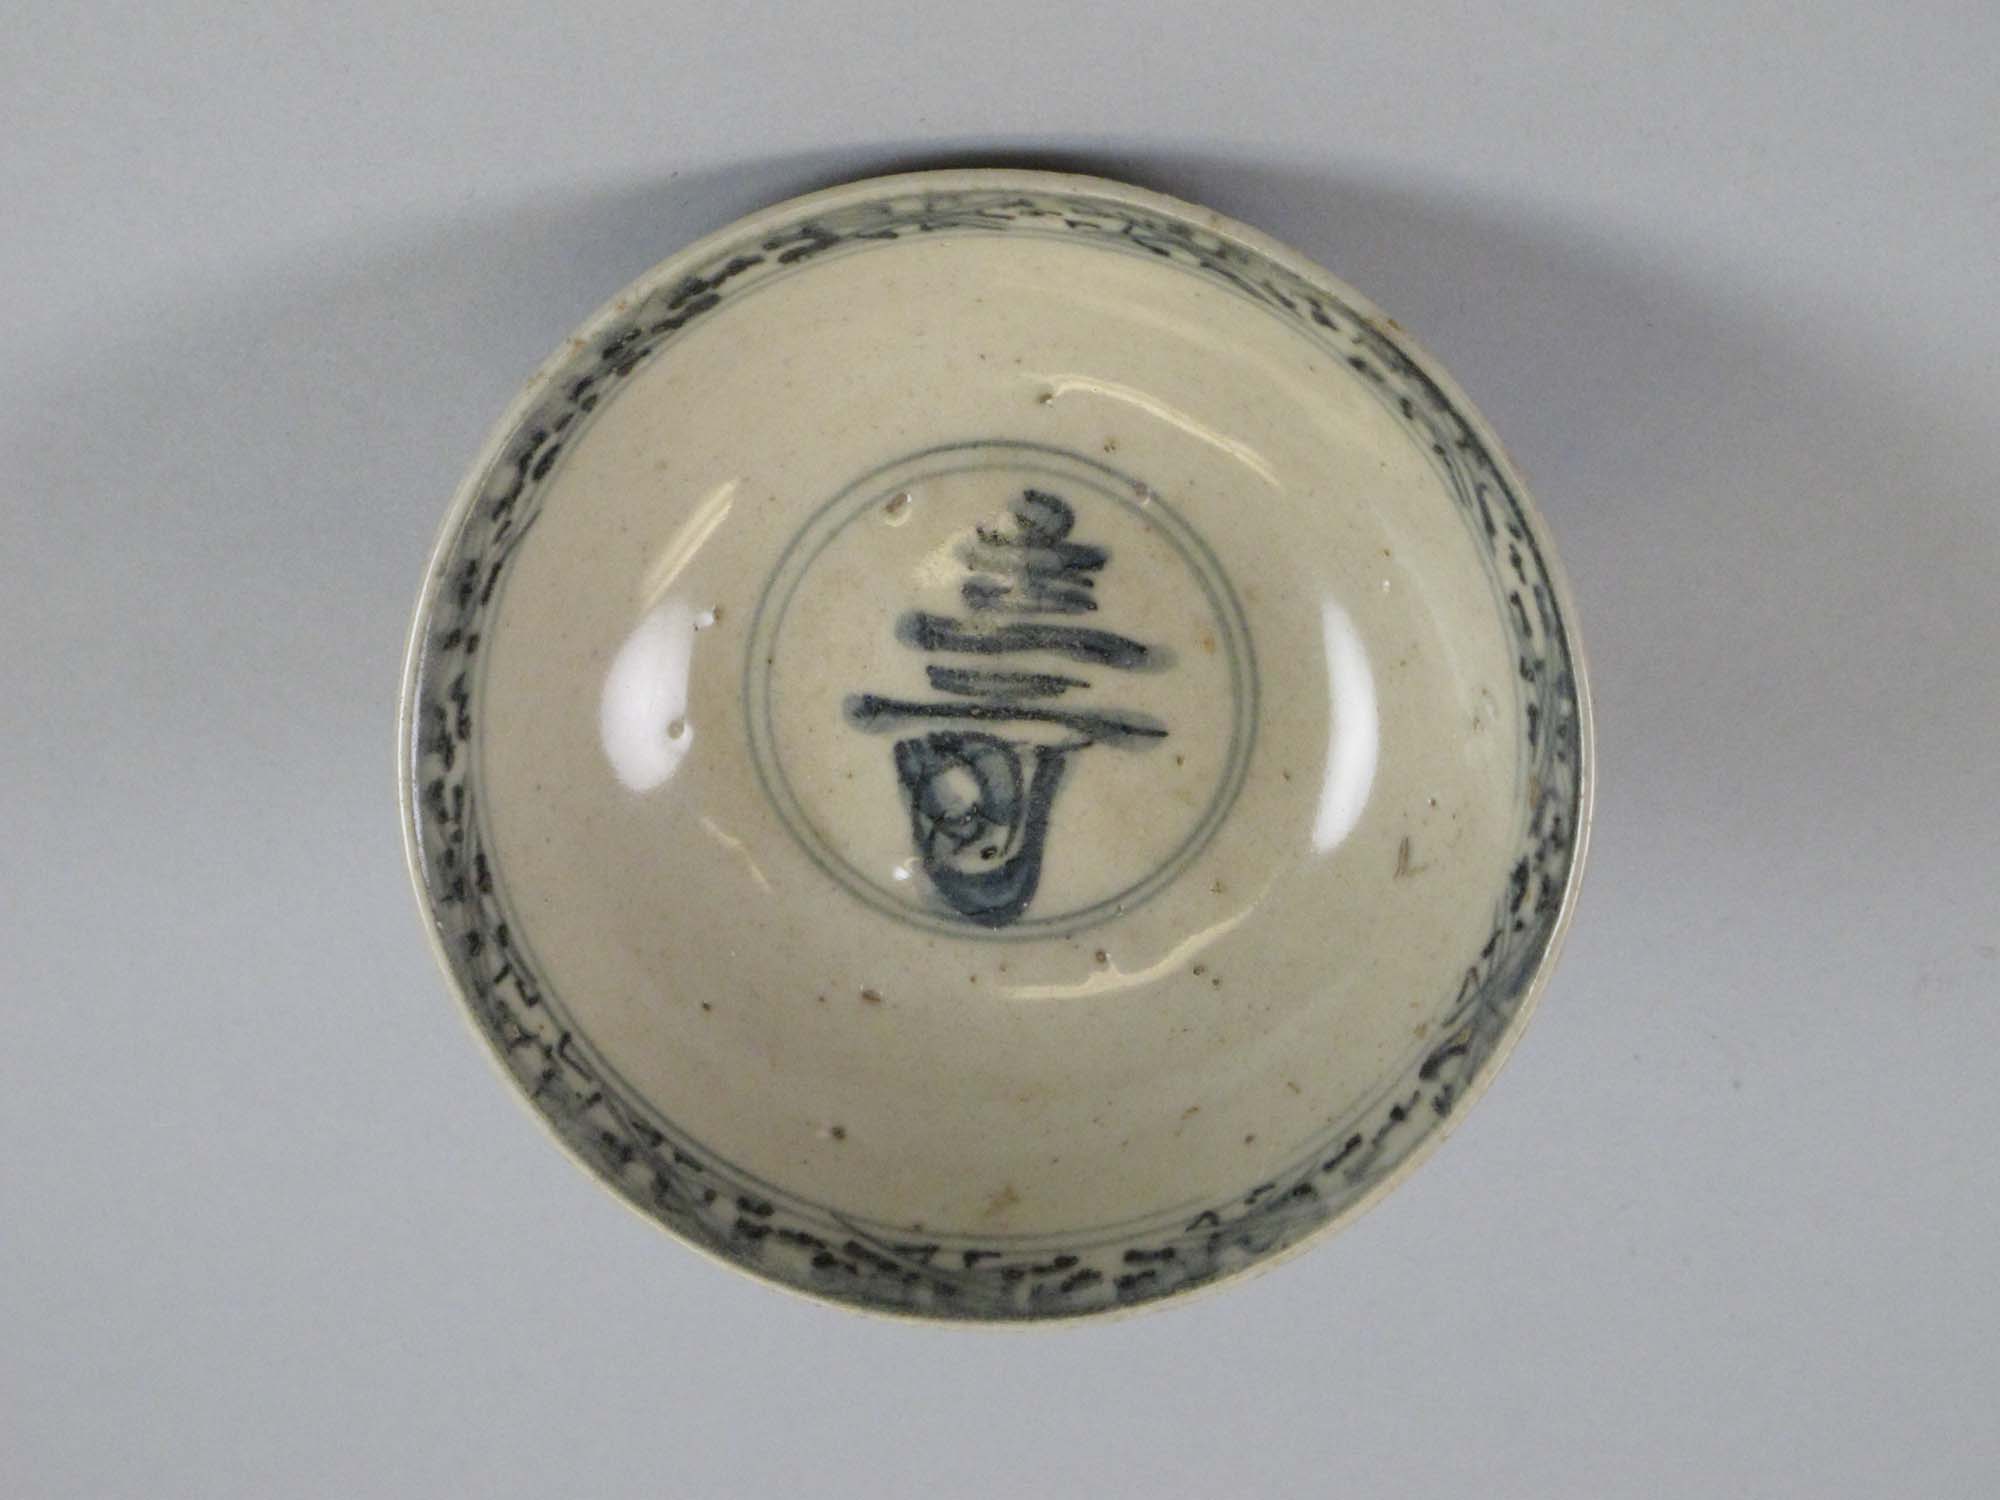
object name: bowl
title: Bowl with character of longevity (shou)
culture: chinese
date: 1567-1633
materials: cobalt, porcelain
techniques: painting, underglaze